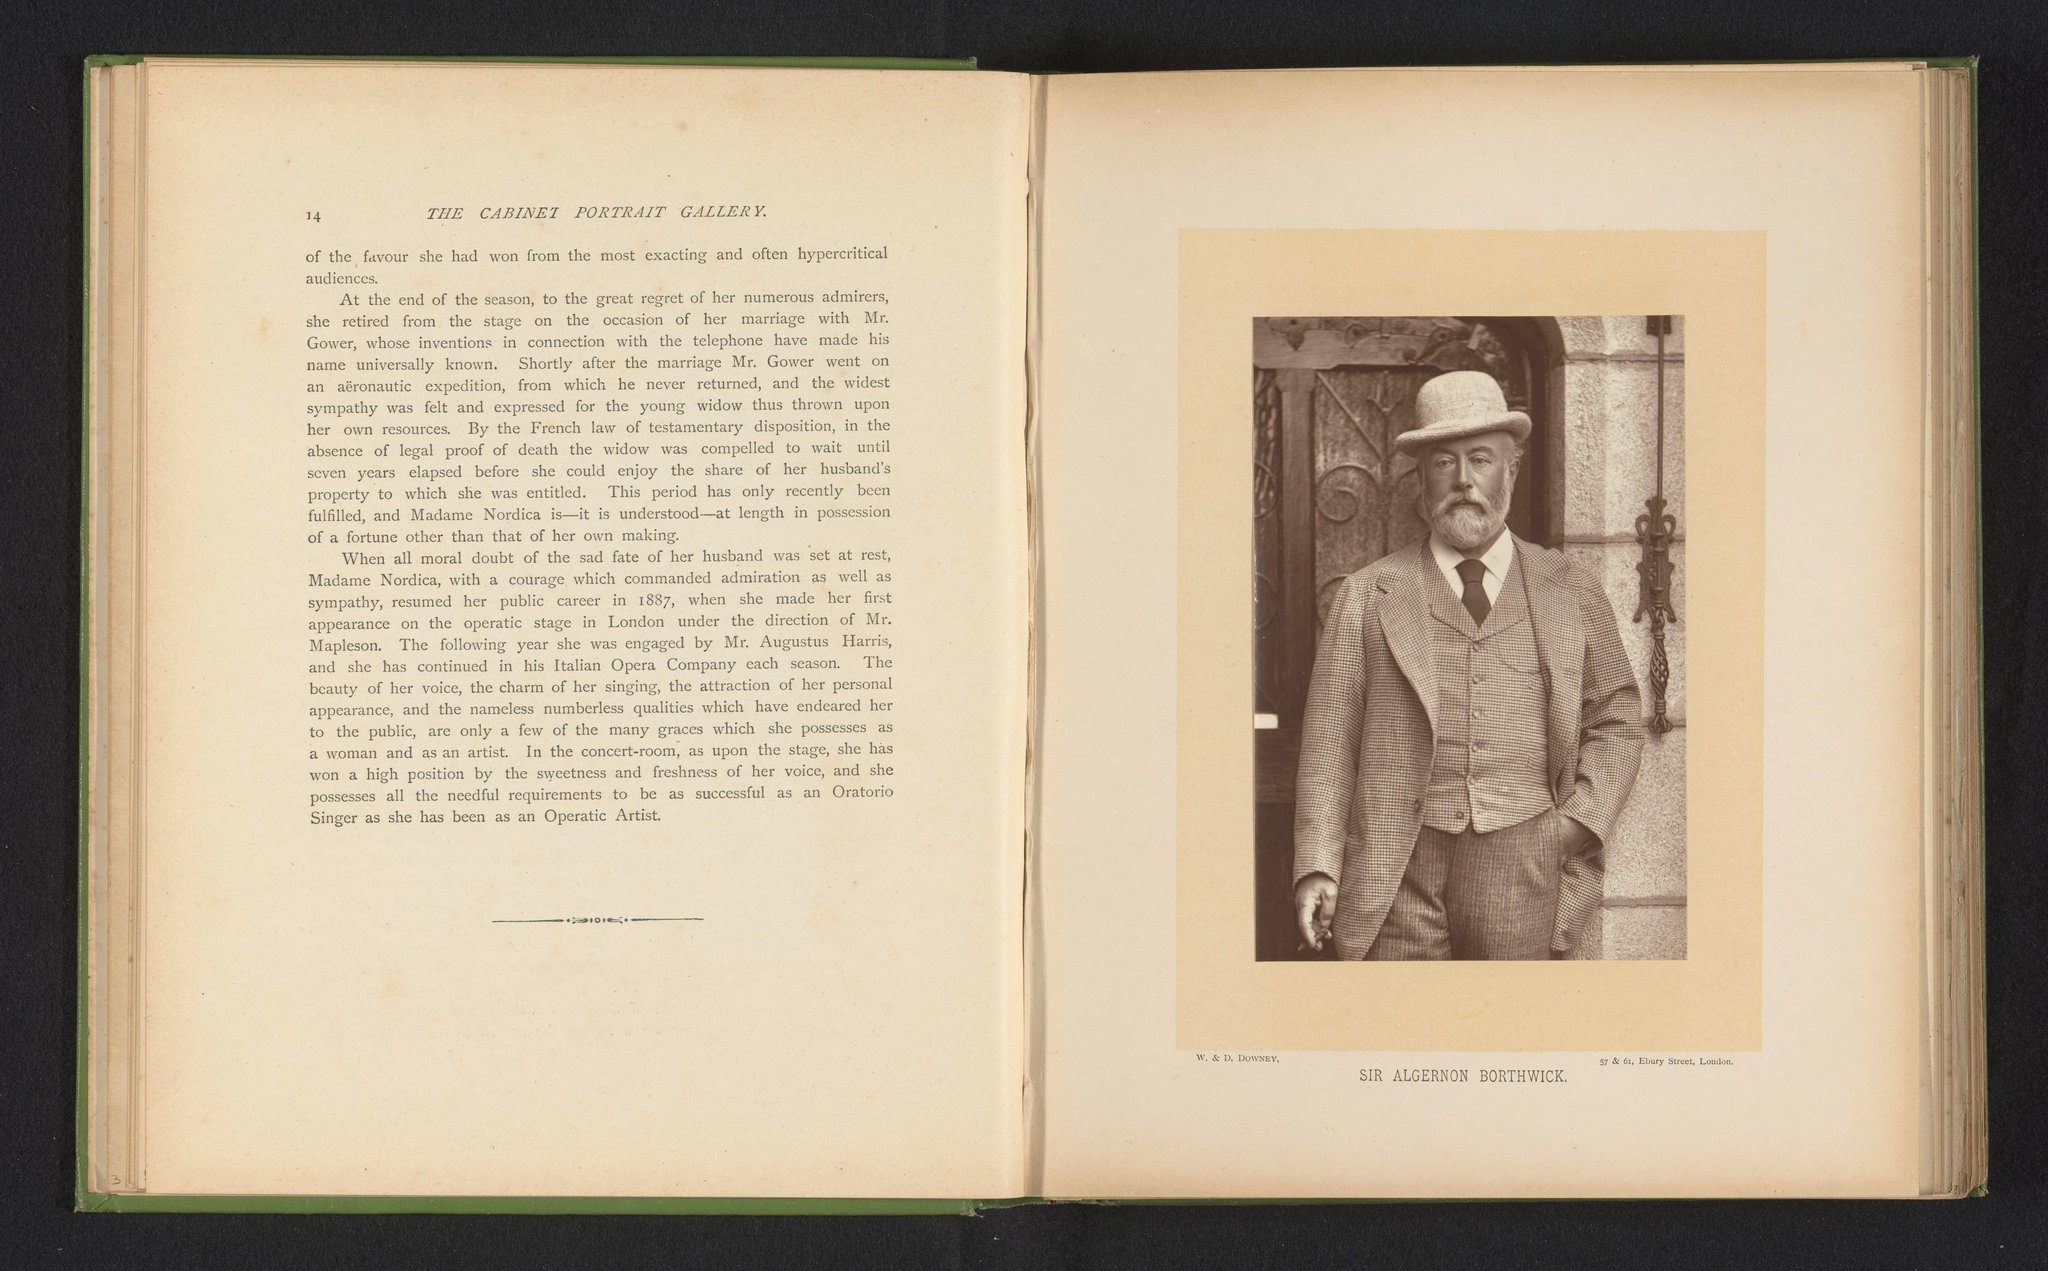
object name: page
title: Portret van Algernon Borthwick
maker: Anonymous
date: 1884-1894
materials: paper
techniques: woodburytype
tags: politician, journalist, reporter, politician, e.g. party leader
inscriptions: inscription: ‘57 & 61, Elbury Street, London.’